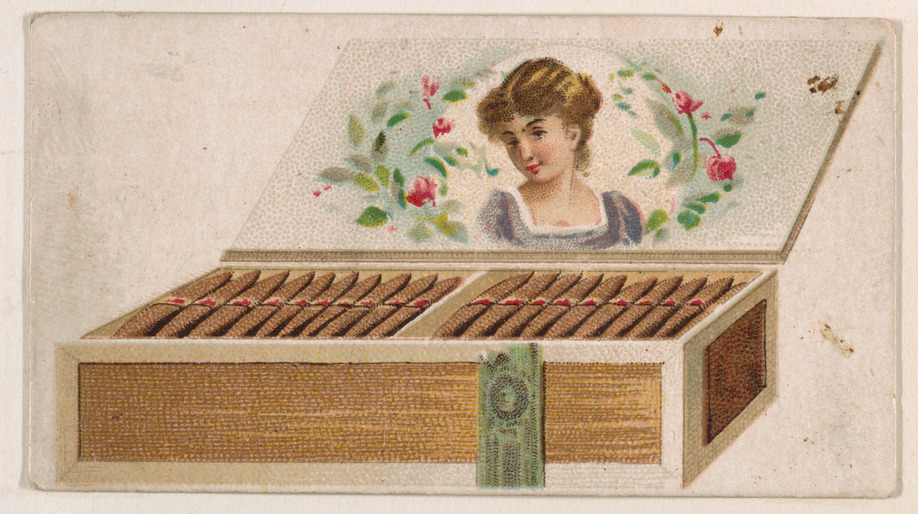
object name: print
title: Cigar box, from the Novelties series (N228, Type 5) issued by Kinney Bros.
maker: kinney brothers tobacco company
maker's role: publisher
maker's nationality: american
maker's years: 1869-2011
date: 1889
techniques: color lithograph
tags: women